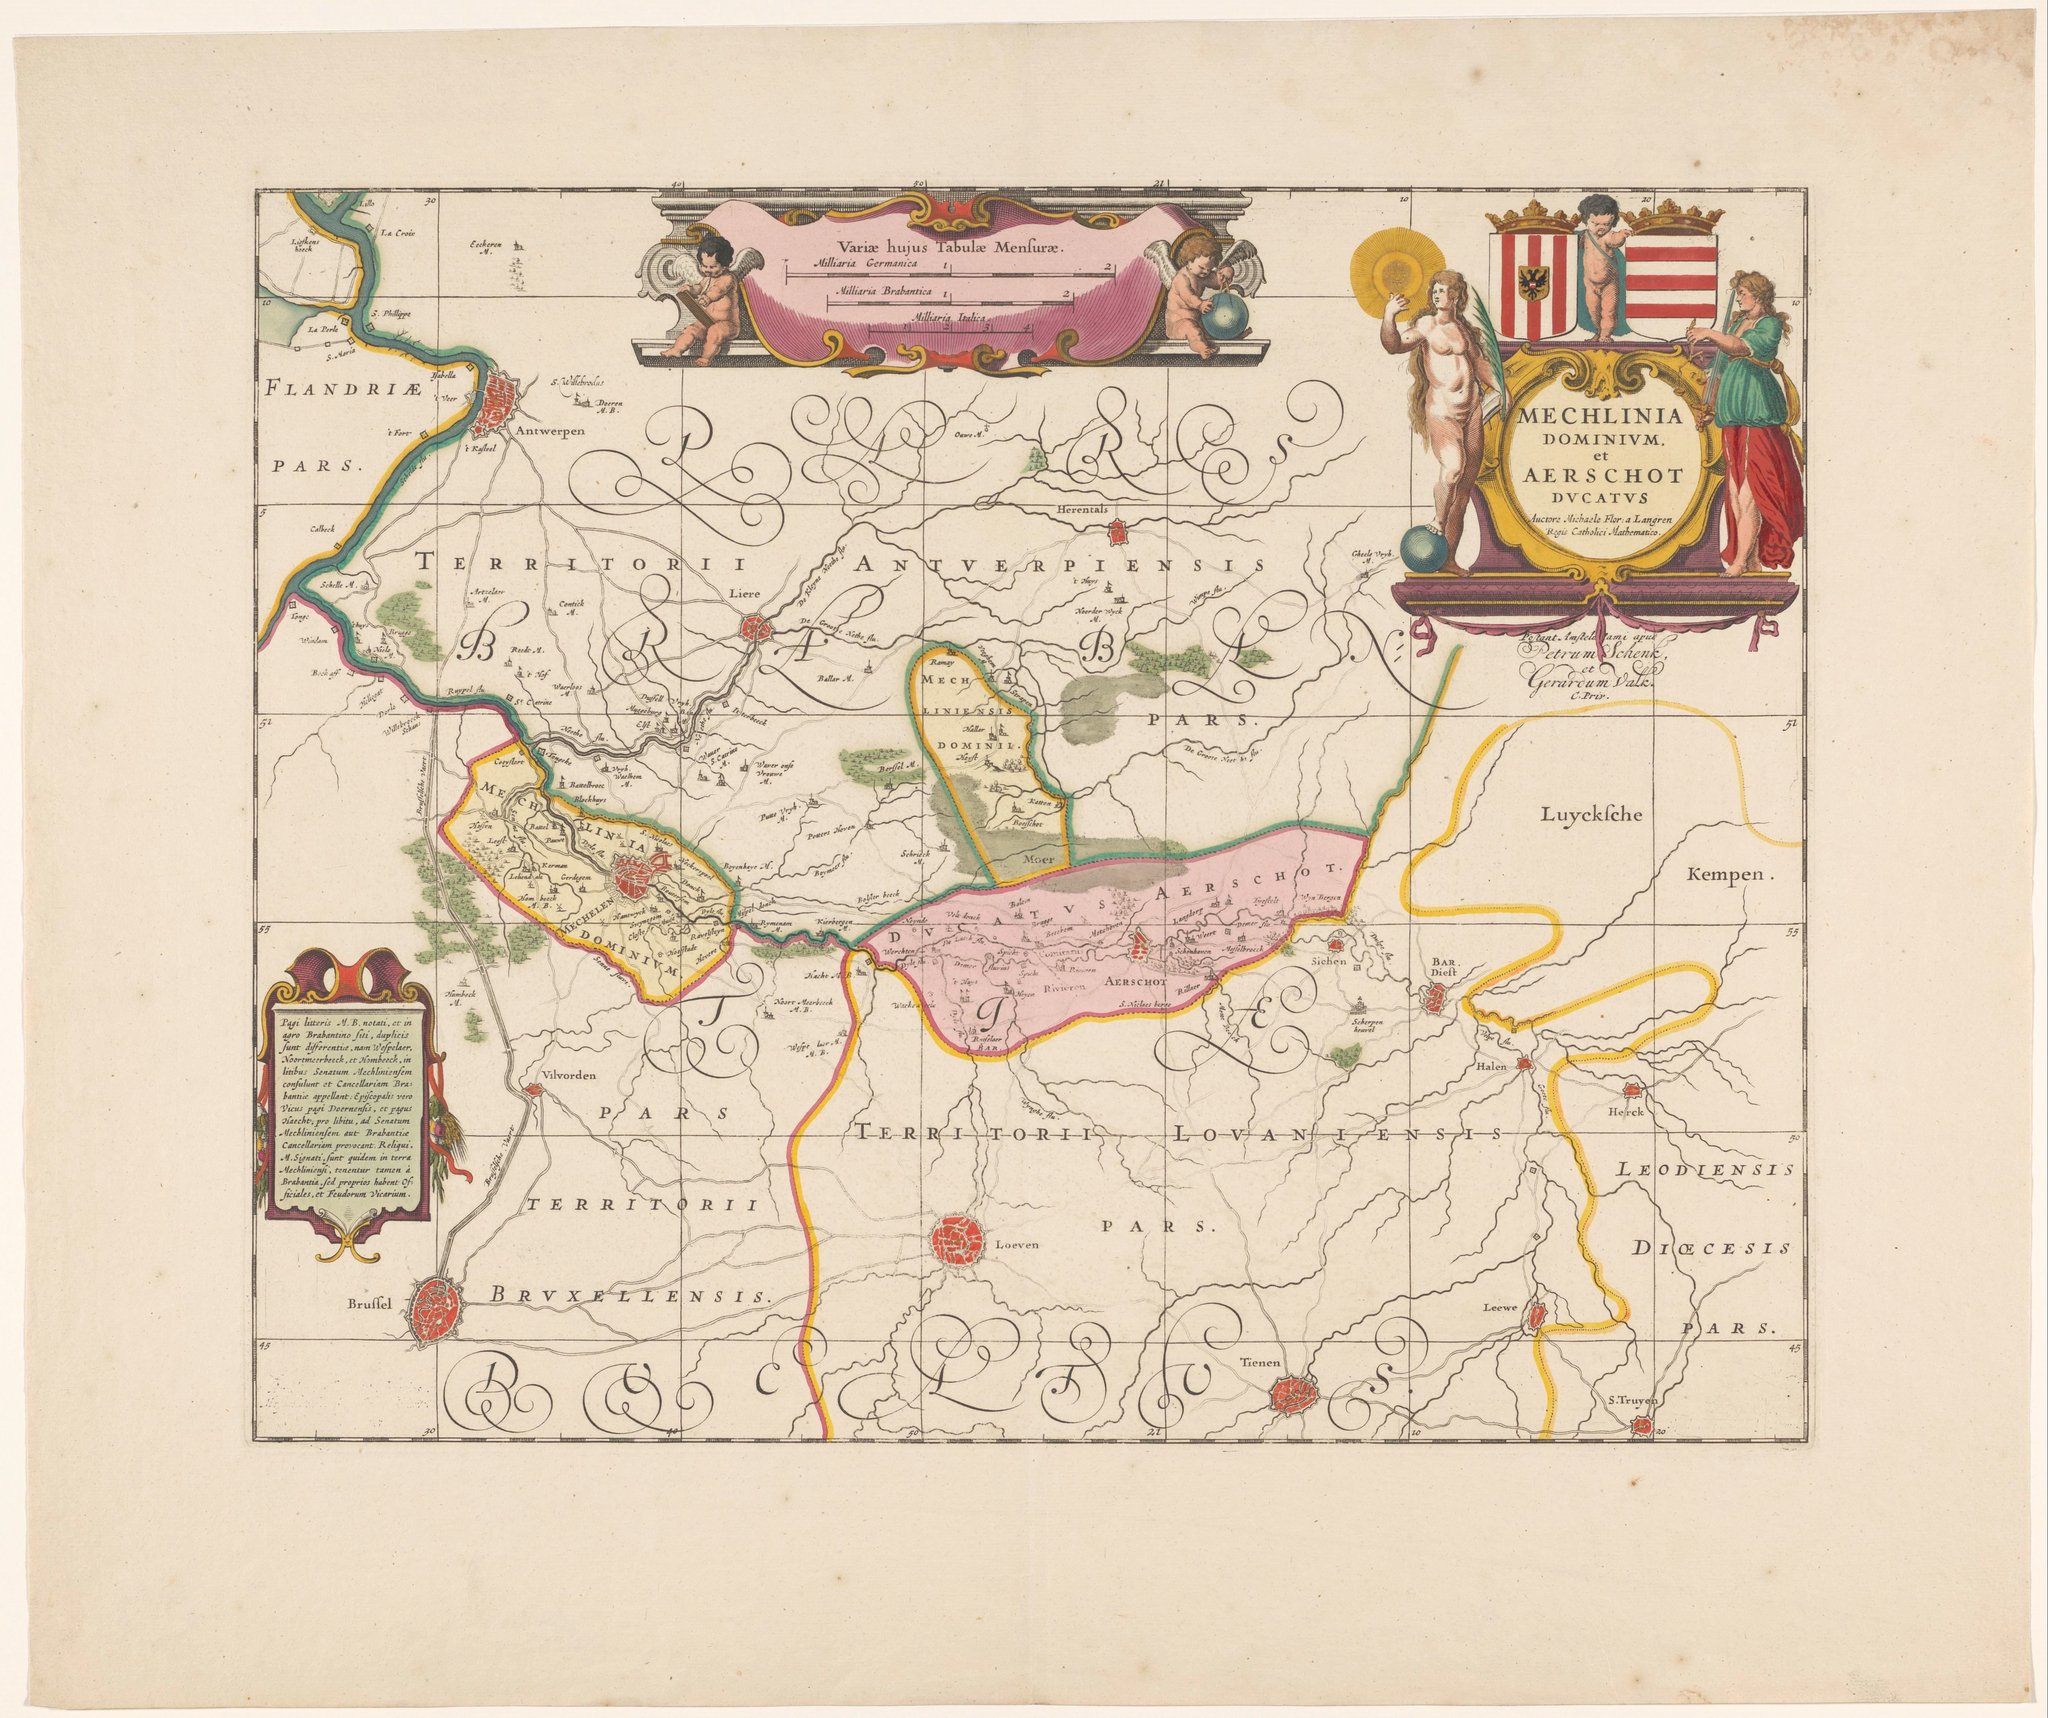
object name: map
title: Tertia pars Brabantiae qua continetur Marchionat (...)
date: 1642-1664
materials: paper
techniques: engraving, etching, hand coloring, letterpress printing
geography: amsterdam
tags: coat of arms (as symbol of the state, etc.) (+ city; municipal), maps of separate countries or regions, (story of) mercury (hermes), globe, coat of arms (as symbol of the state, etc.) (+ province; provincial), brabant, antwerp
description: Huidige staat van prent gebruikt in: Blaeu, Willem Janszoon en Johannes Willemszoon Blaeu. Toonneel des aerdriicx, ofte nieuwe Atlas, dat is de beschryving van alle landen. 3 delen. Amsterdam: Johannes Willemszoon Blaeu, 1642-1643, dl. 1 (1642). Of in: Blaeu, Willem Janszoon en Johannes Willemszoon Blaeu. Toonneel des aerdrycx, ofte nieuwe Atlas, dat is de beschryving van alle landen. 4 delen. Amsterdam: Johannes Willemszoon Blaeu, 1647-1650, dl. 1 (1647-1648). Of in: Blaeu, Willem Janszoon en Johannes Willemszoon Blaeu. Toonneel des aerdrycx, ofte nieuwe Atlas, dat is de beschryving van alle landen. 4 delen. Amsterdam: Johannes Willemszoon Blaeu, 1649-1650, dl. 1 (1649). Of in: Blaeu, Willem Janszoon en Johannes Willemszoon Blaeu. Toonneel des aerdriicx, ofte niuew Atlas, dat is beschryving van alle landen. 6 delen. Amsterdam: Johannes Willemszoon Blaeu, 1658-1661, dl. 1. Of in: Blaeu, Johannes Willemszoon. J. Blaeus grooten atlas oft wereltbeschyving, in welcke 't aerdryck, de zee, en hemel, wort vertoont en beschreven. 9 delen. Amsterdam: Johannes Willlemszoon Blaeu, 1664-1665, dl. 3 (1664).